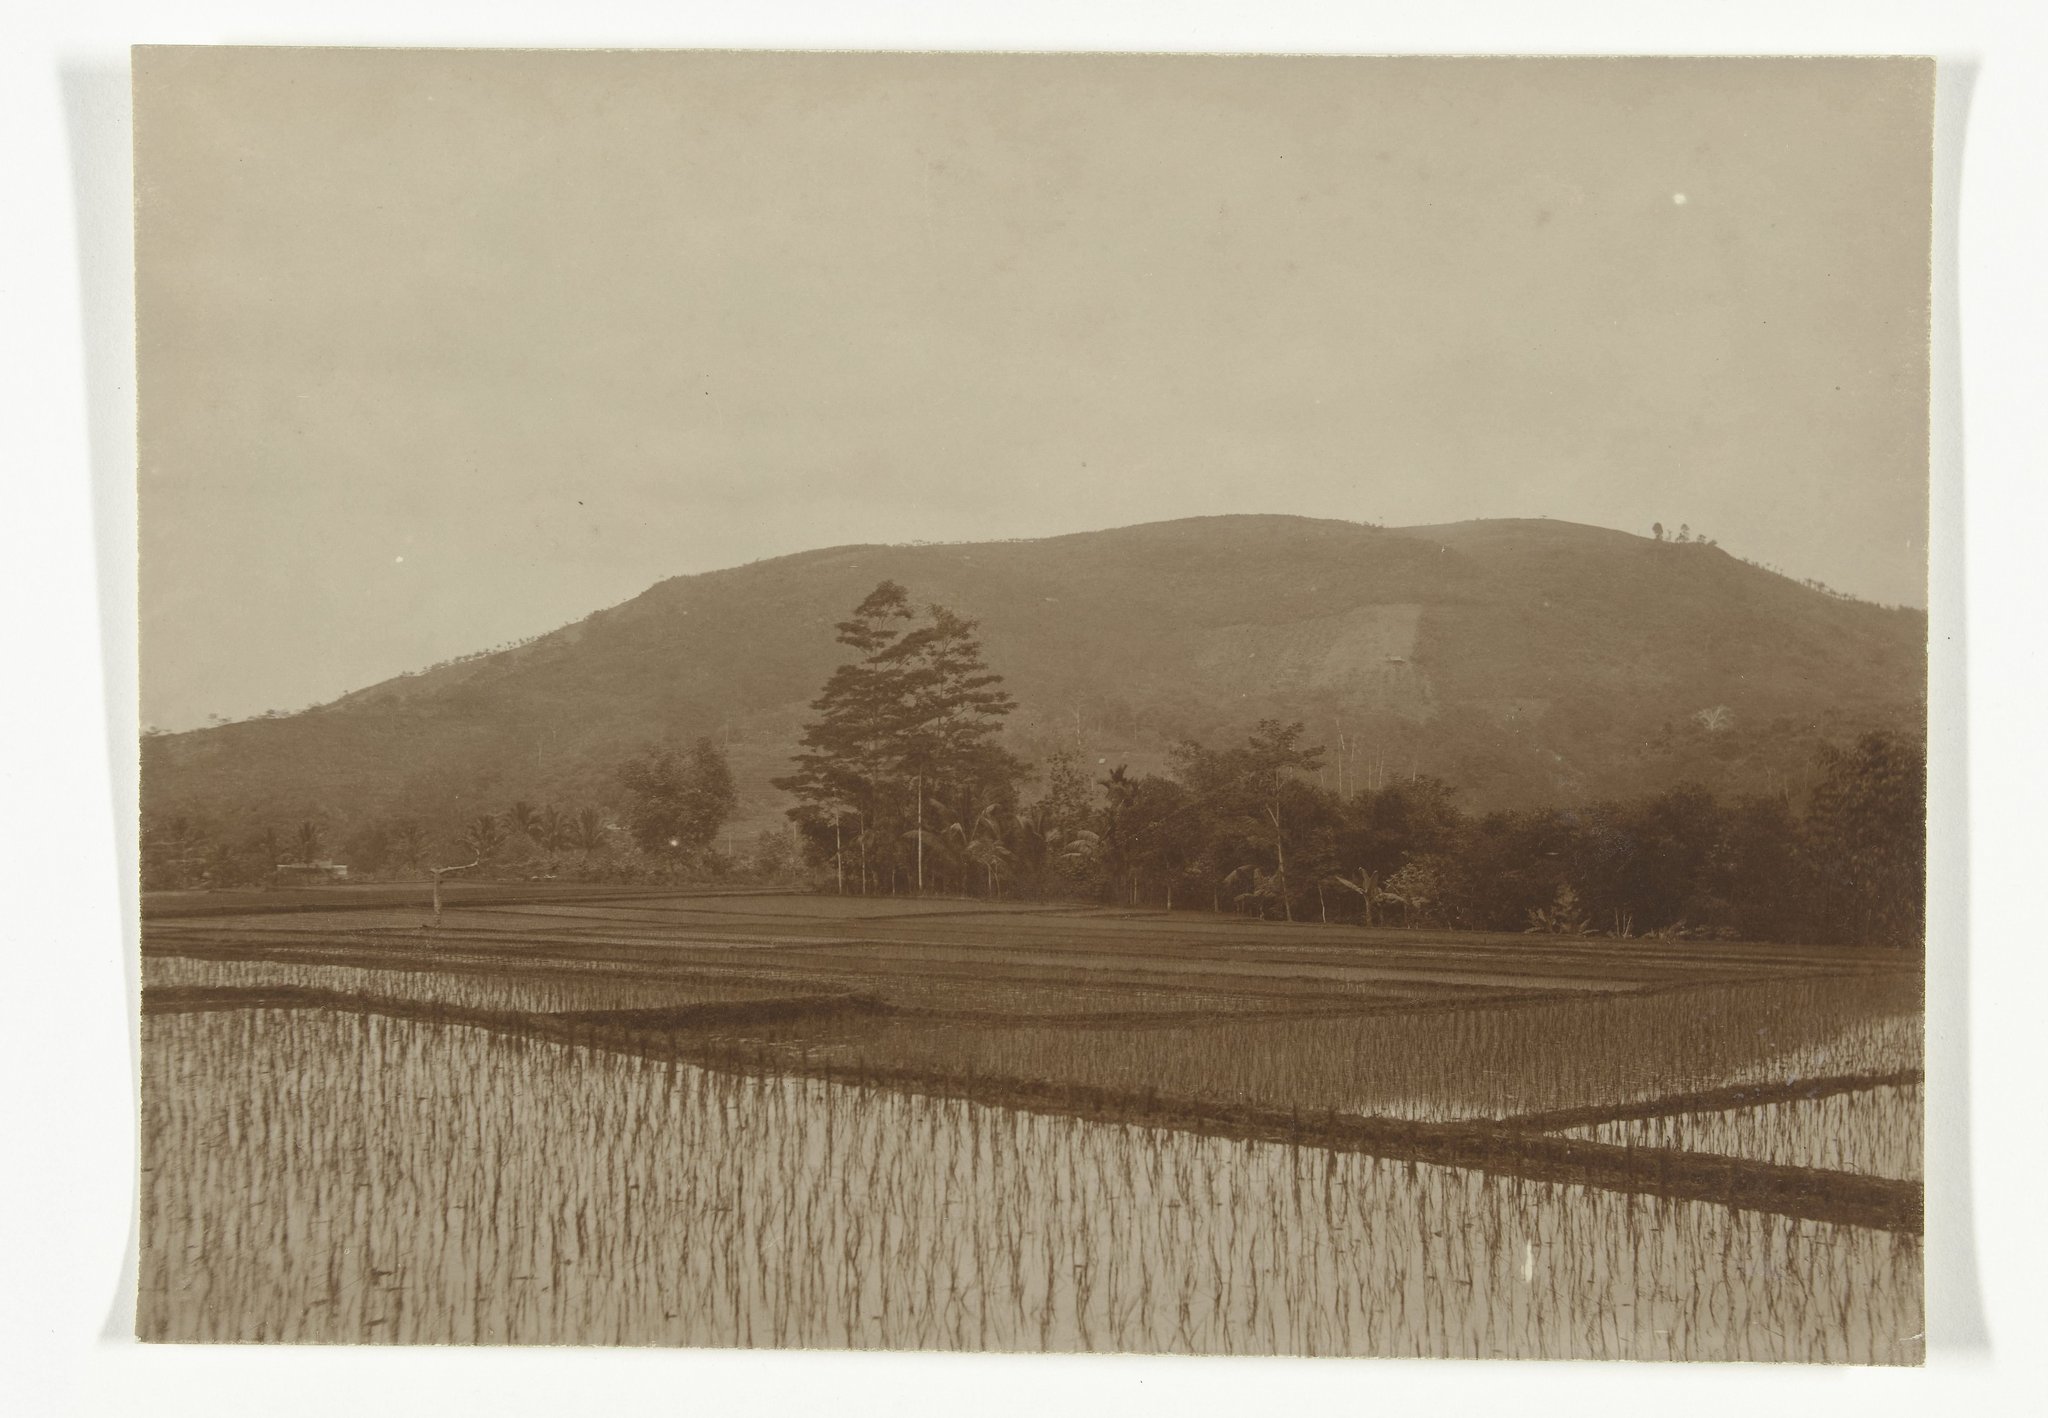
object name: photograph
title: Landschap met sawah, voormalig Nederlands-Indië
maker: onnes kurkdjian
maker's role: fotograaf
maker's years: 1851-1903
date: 1900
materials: paper, photographic support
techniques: gelatin silver print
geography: surabaya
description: Landschap met sawah, voormalig Nederlands-Indië. Rijstvelden op de voorgrond en een berg op de achtergrond.